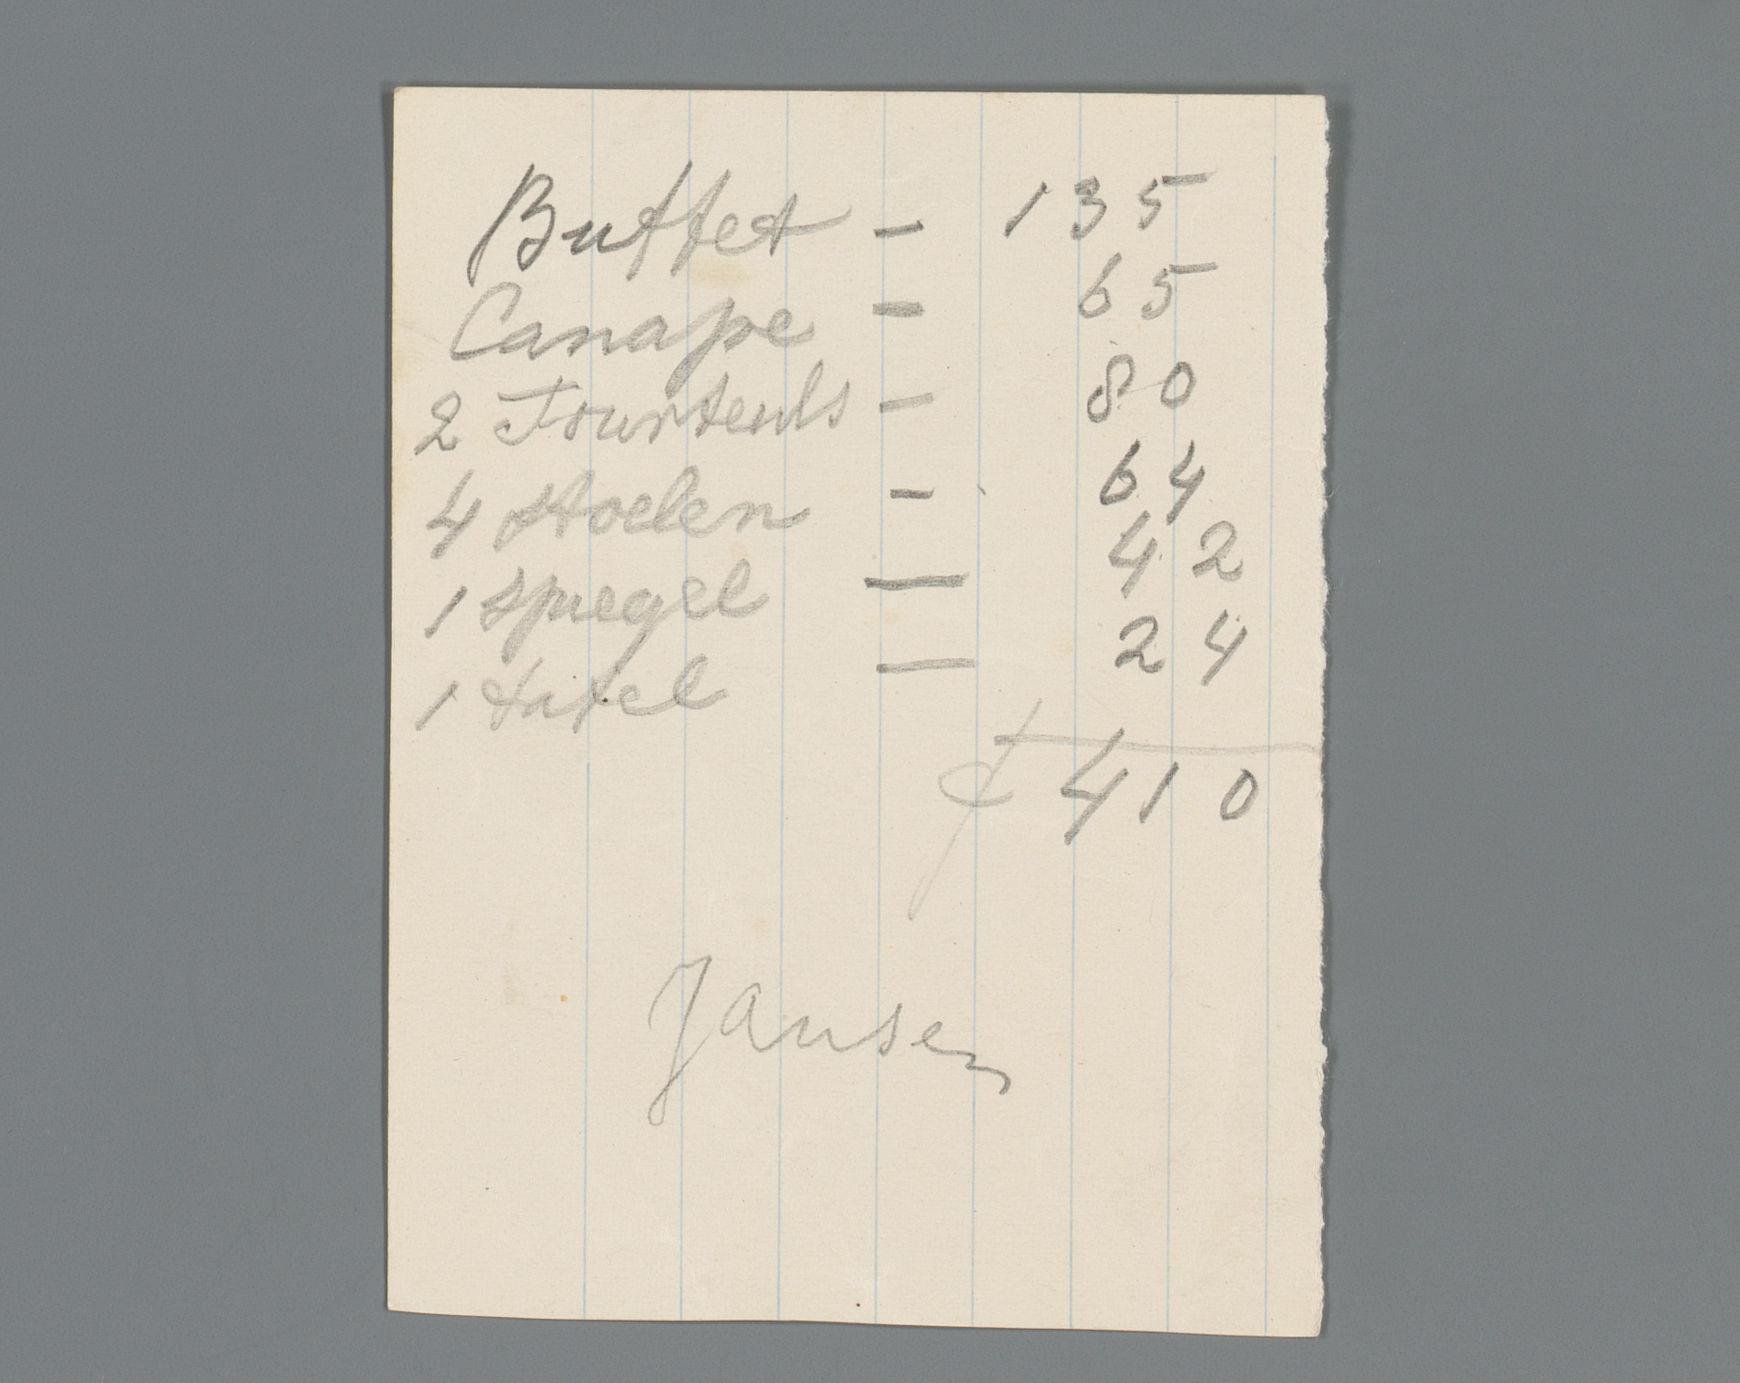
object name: document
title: Lijstje met prijzen voor meubels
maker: gust van de wall perné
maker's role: draughtsman, painter, print maker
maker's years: 1877-1911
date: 1900-1910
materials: paper, pencil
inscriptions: collector's mark: Lugt 2228